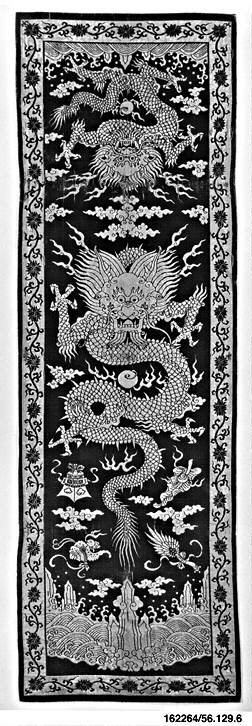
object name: chair strip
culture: chinese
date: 1701-1733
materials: metal thread, silk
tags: dragons